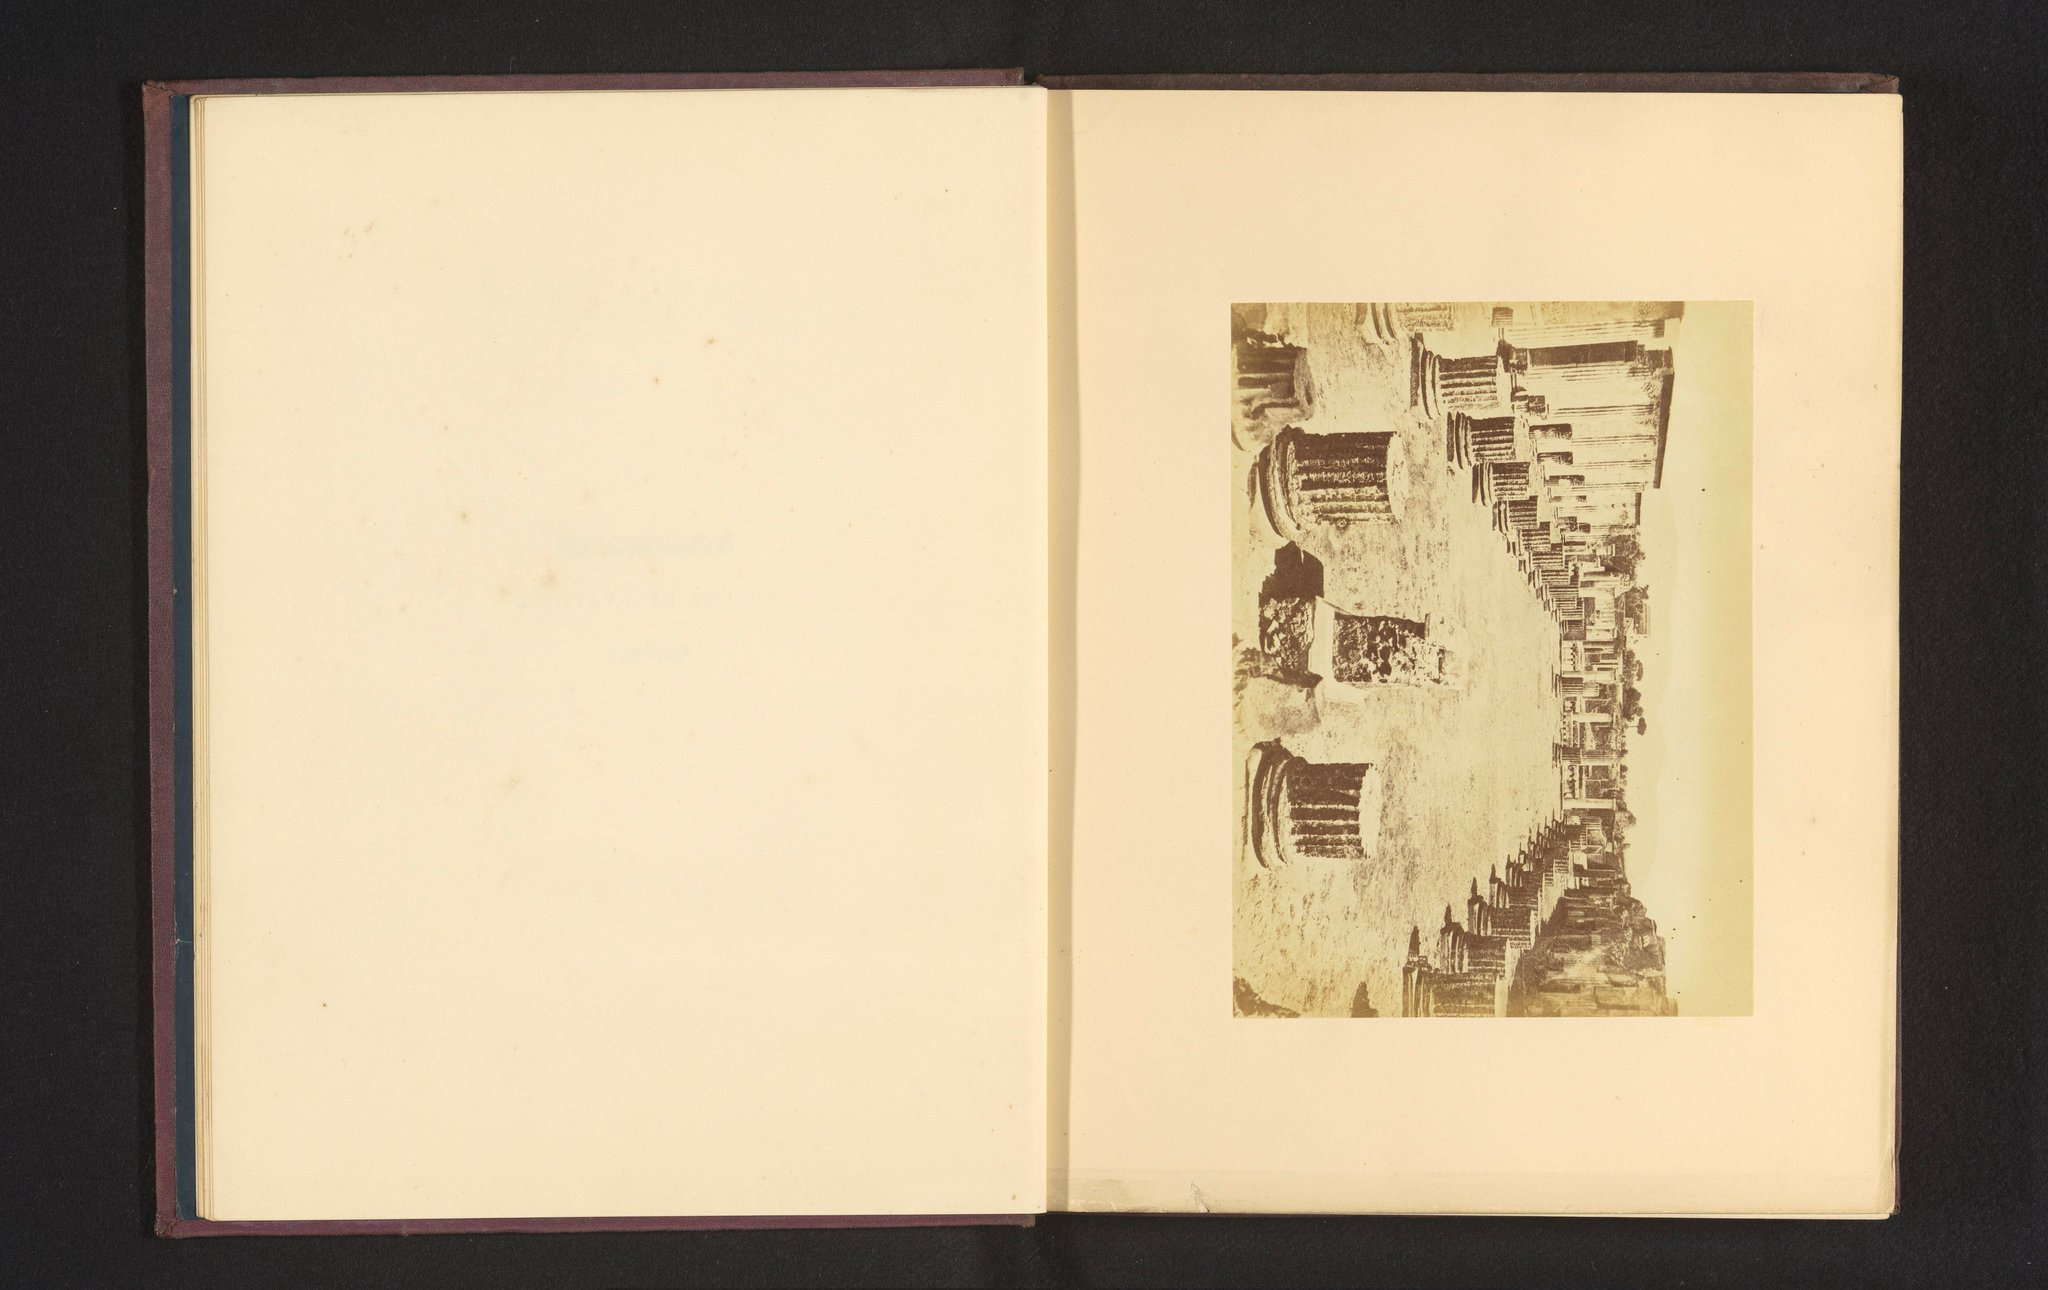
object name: photograph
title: Gezicht op een rij zuilen te Pompeï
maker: Anonymous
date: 1862-1867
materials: cardboard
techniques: albumen print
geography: pompeii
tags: column, pillar ~ architecture, landscape with ruins, pompeii